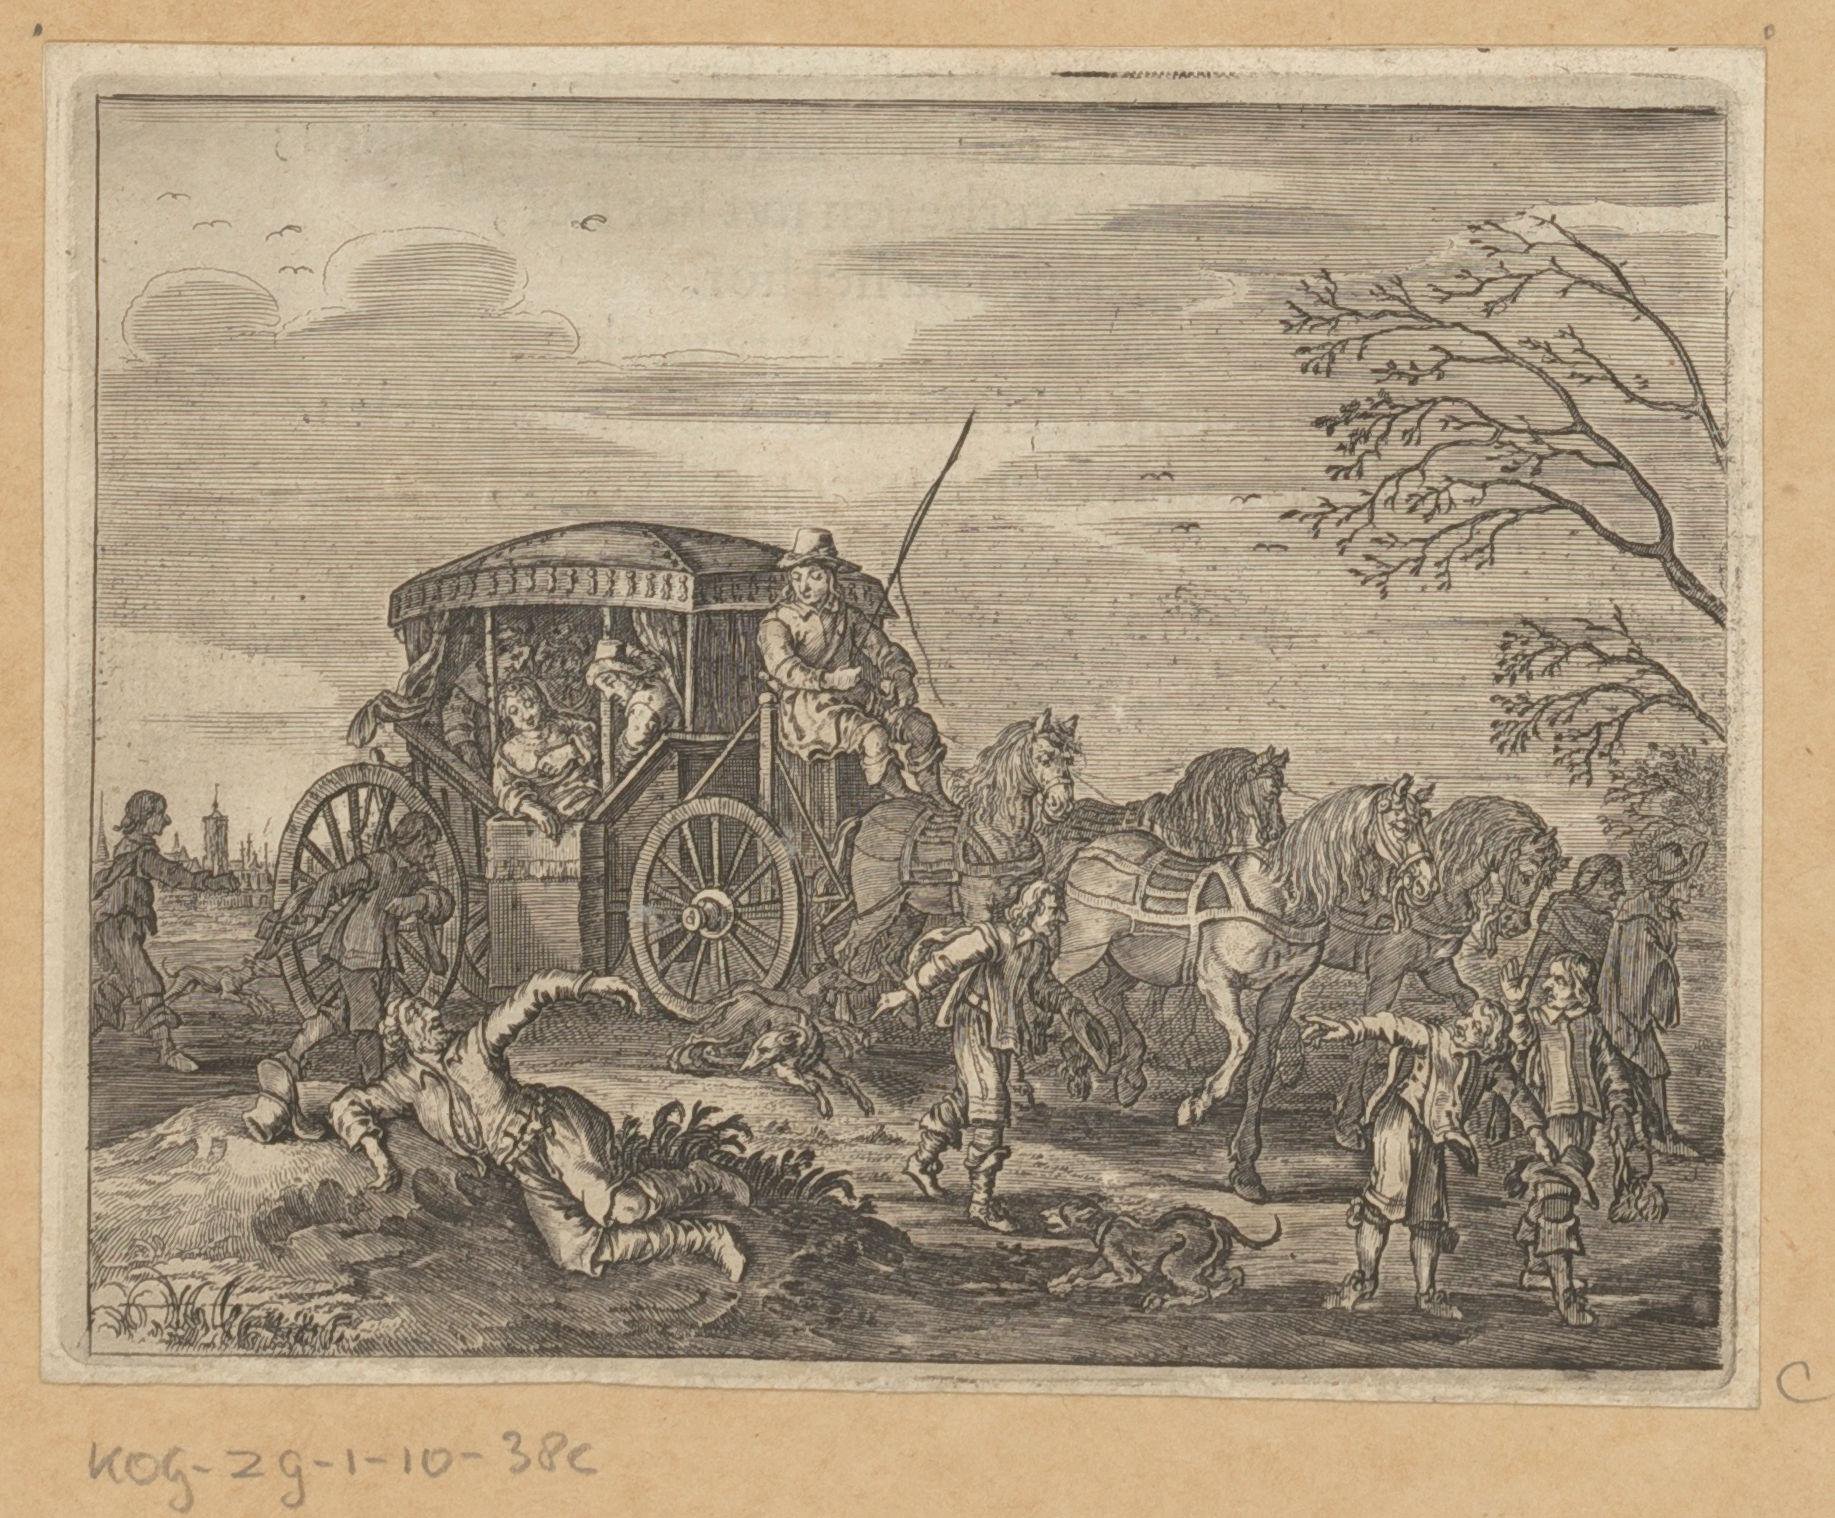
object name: print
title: Koets stopt bij een dronken man die in de berm ligt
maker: Anonymous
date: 1659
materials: paper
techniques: engraving, etching, letterpress printing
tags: four-wheeled, animal-drawn vehicle, e.g.: cab, carriage, coach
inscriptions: stamp, collector's mark: Lugt 1641, stamp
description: Boekillustratie bij het verhaal: 't Leven duydelijck af-gebeeldt door een wakenden droom. Een verhaal over prins Philips die een dronken man meeneemt naar het hof. Onderwerpsrubrieken binnen de Atlas Zeden en Gewoonten: Vervoermiddelen te land en te water, Vervoermiddelen te land, Reiskoetsen en post.